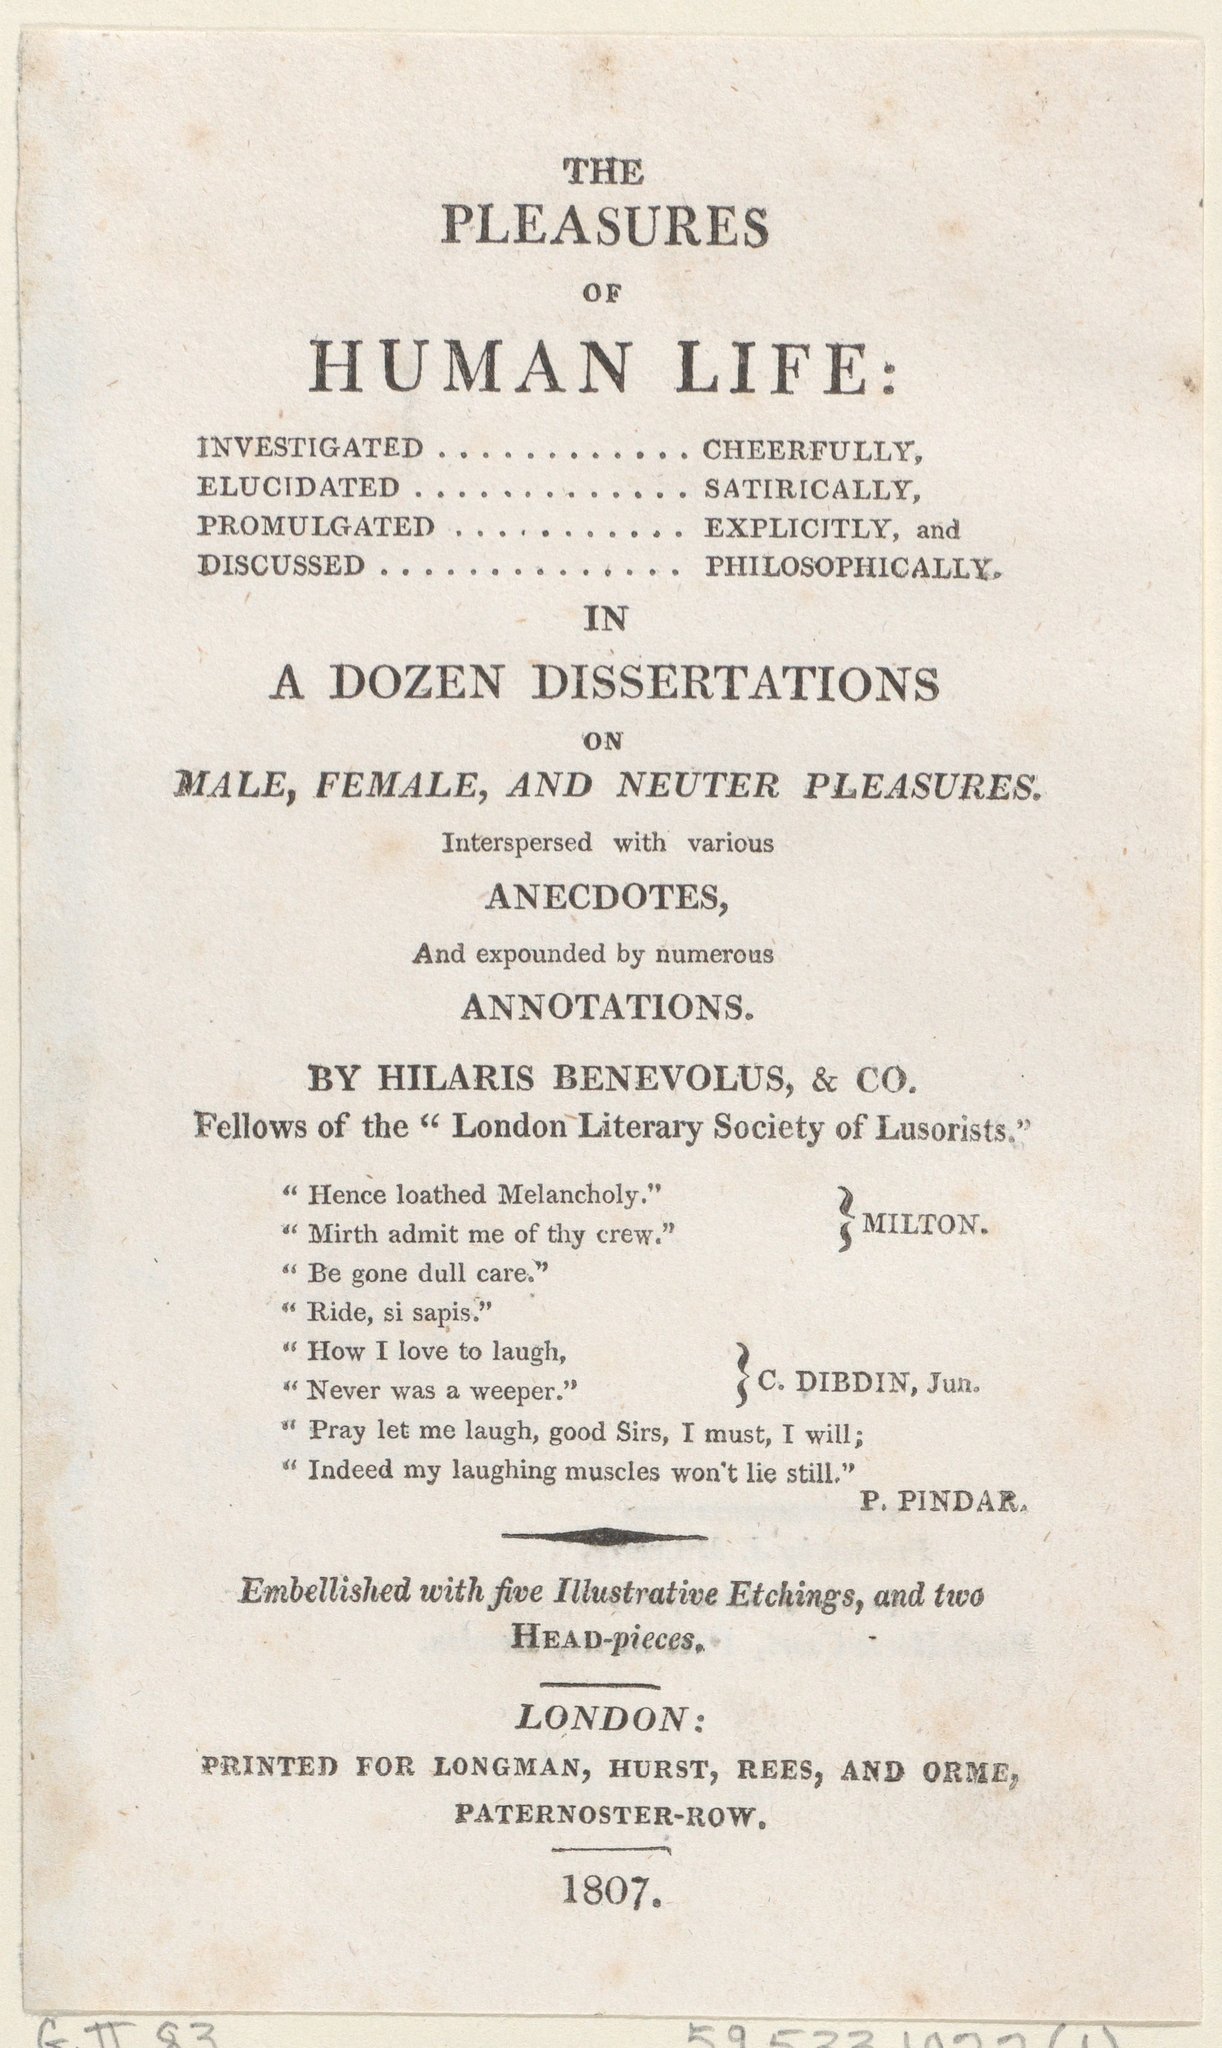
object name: print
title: The Pleasures of Human Life: Title Page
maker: thomas rowlandson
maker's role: artist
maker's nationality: british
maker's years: 1757-1827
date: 1807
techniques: letterpress